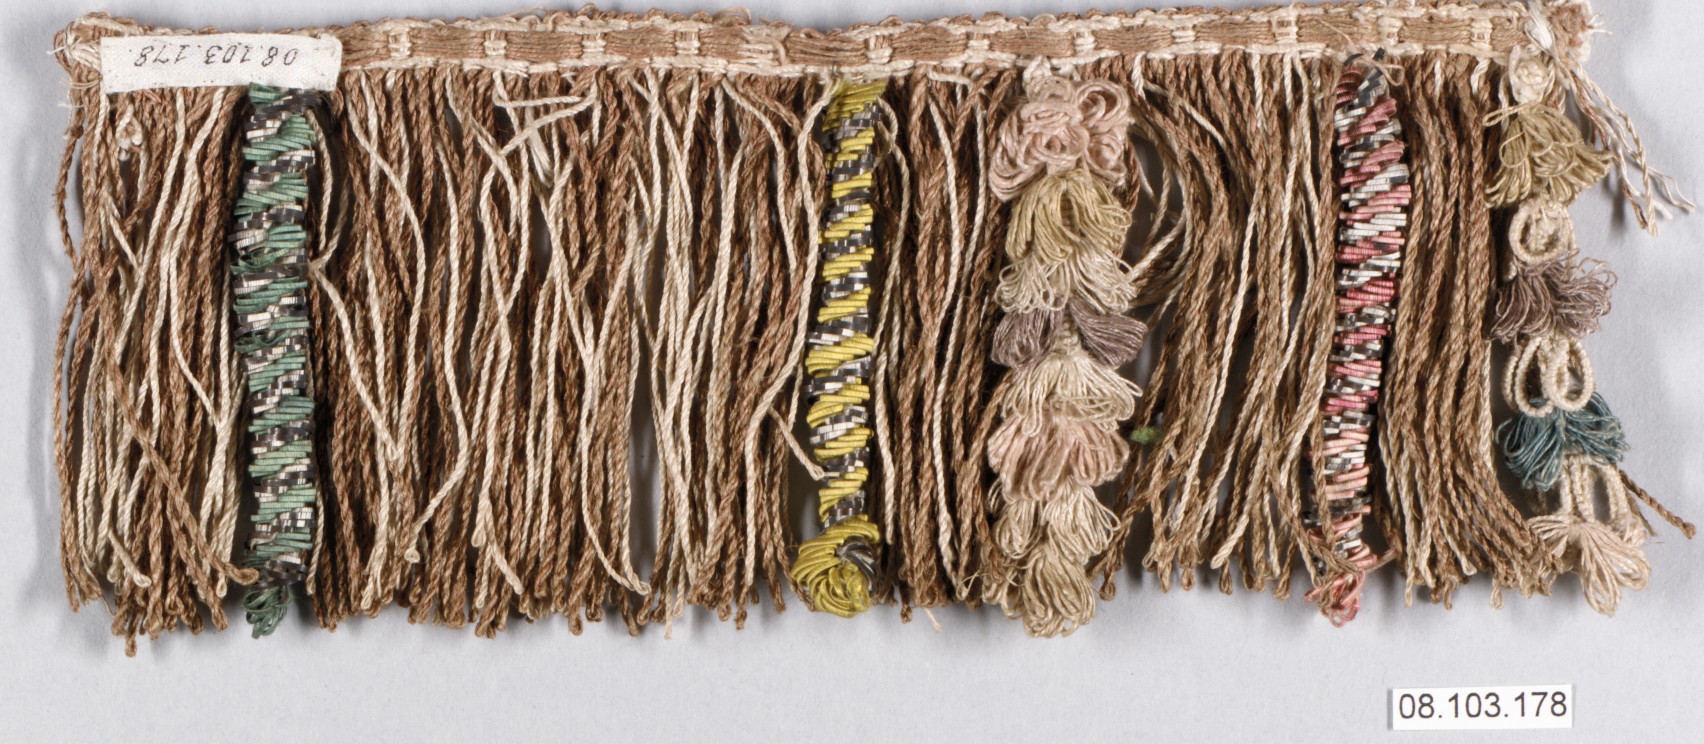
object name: fringe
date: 1601-1800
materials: cotton